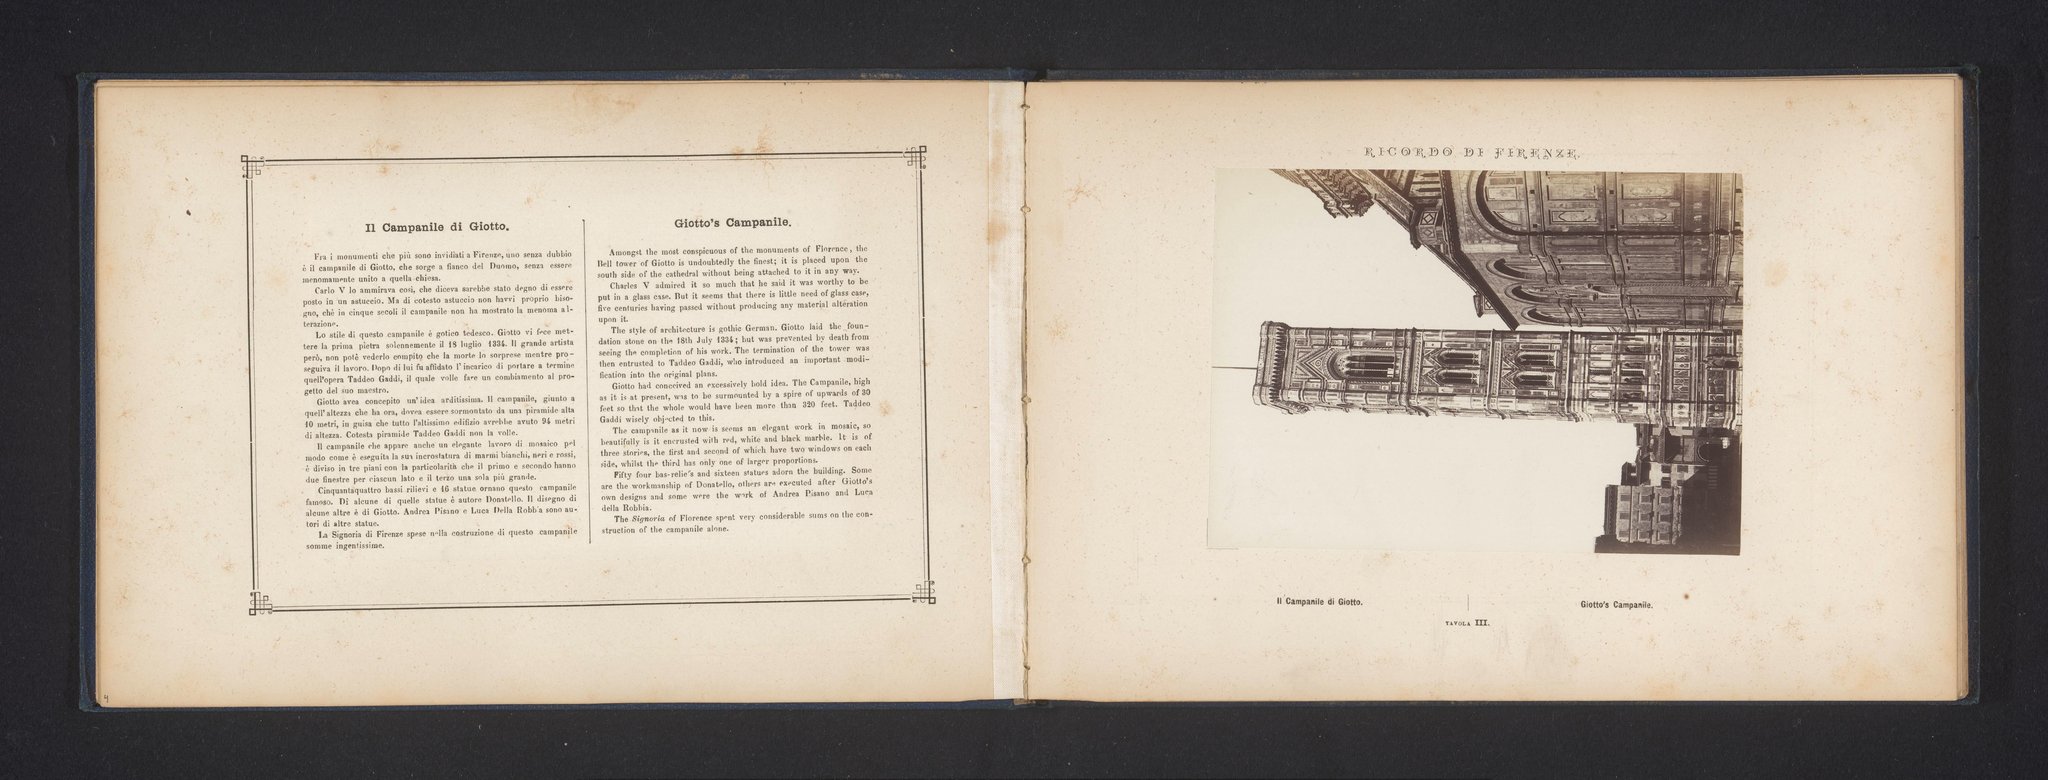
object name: photograph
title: Gezicht op de Campanile in Florence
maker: giacomo brogi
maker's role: fotograaf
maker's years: 1822-1881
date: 1861-1871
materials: photographic support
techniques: albumen print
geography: florence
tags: parts of church exterior and annexes: campanile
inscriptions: number: ‘Tavola III.’